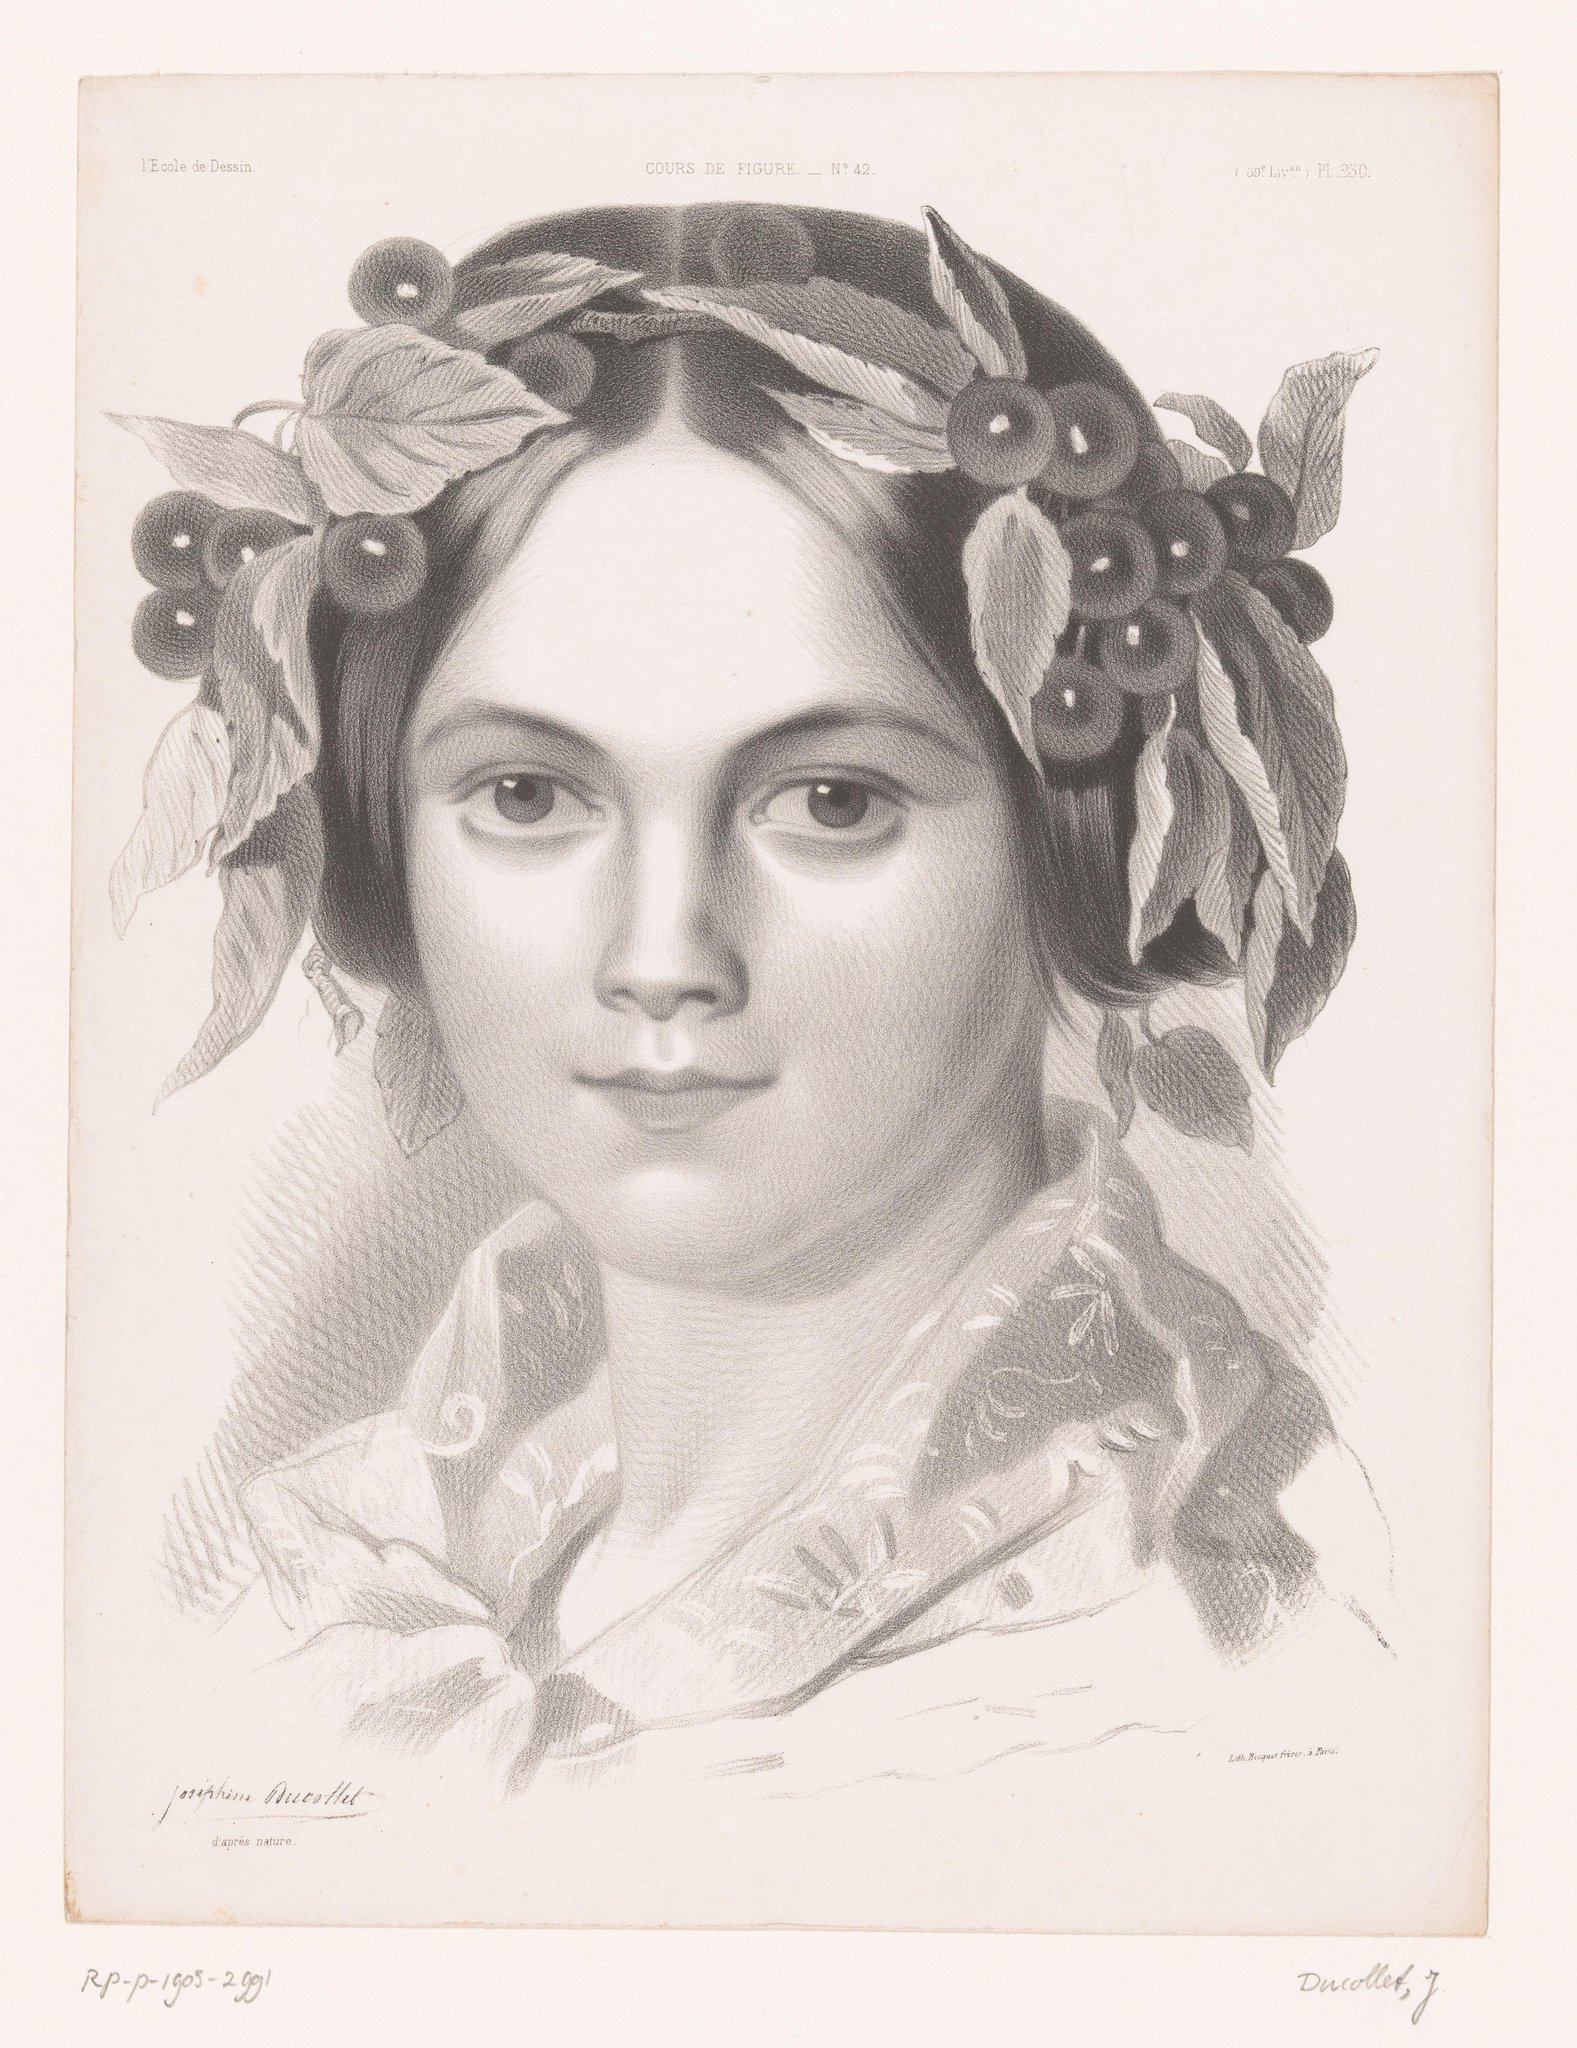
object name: print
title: Hoofd van een meisje met kersen in het haar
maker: josephine ducollet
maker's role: print maker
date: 1846-1876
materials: paper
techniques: lithograph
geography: paris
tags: adolescent, young woman, maiden, fruits: cherry, head (human) - aa - female human figure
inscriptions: collector's mark: Lugt 2228a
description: Prent gebruikt voor: L'École de Dessin, 39e livraison (pl. 230).